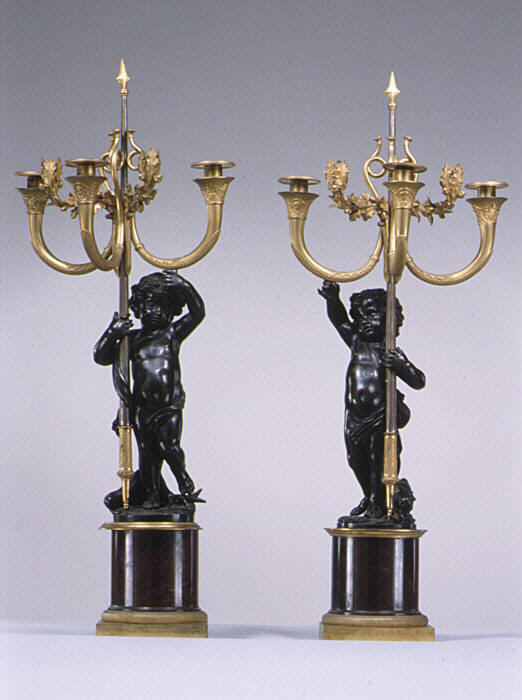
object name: candelabrum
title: Pedestals with five-light candelabra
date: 1785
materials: bronze, gilt bronze, marble, steel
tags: putti